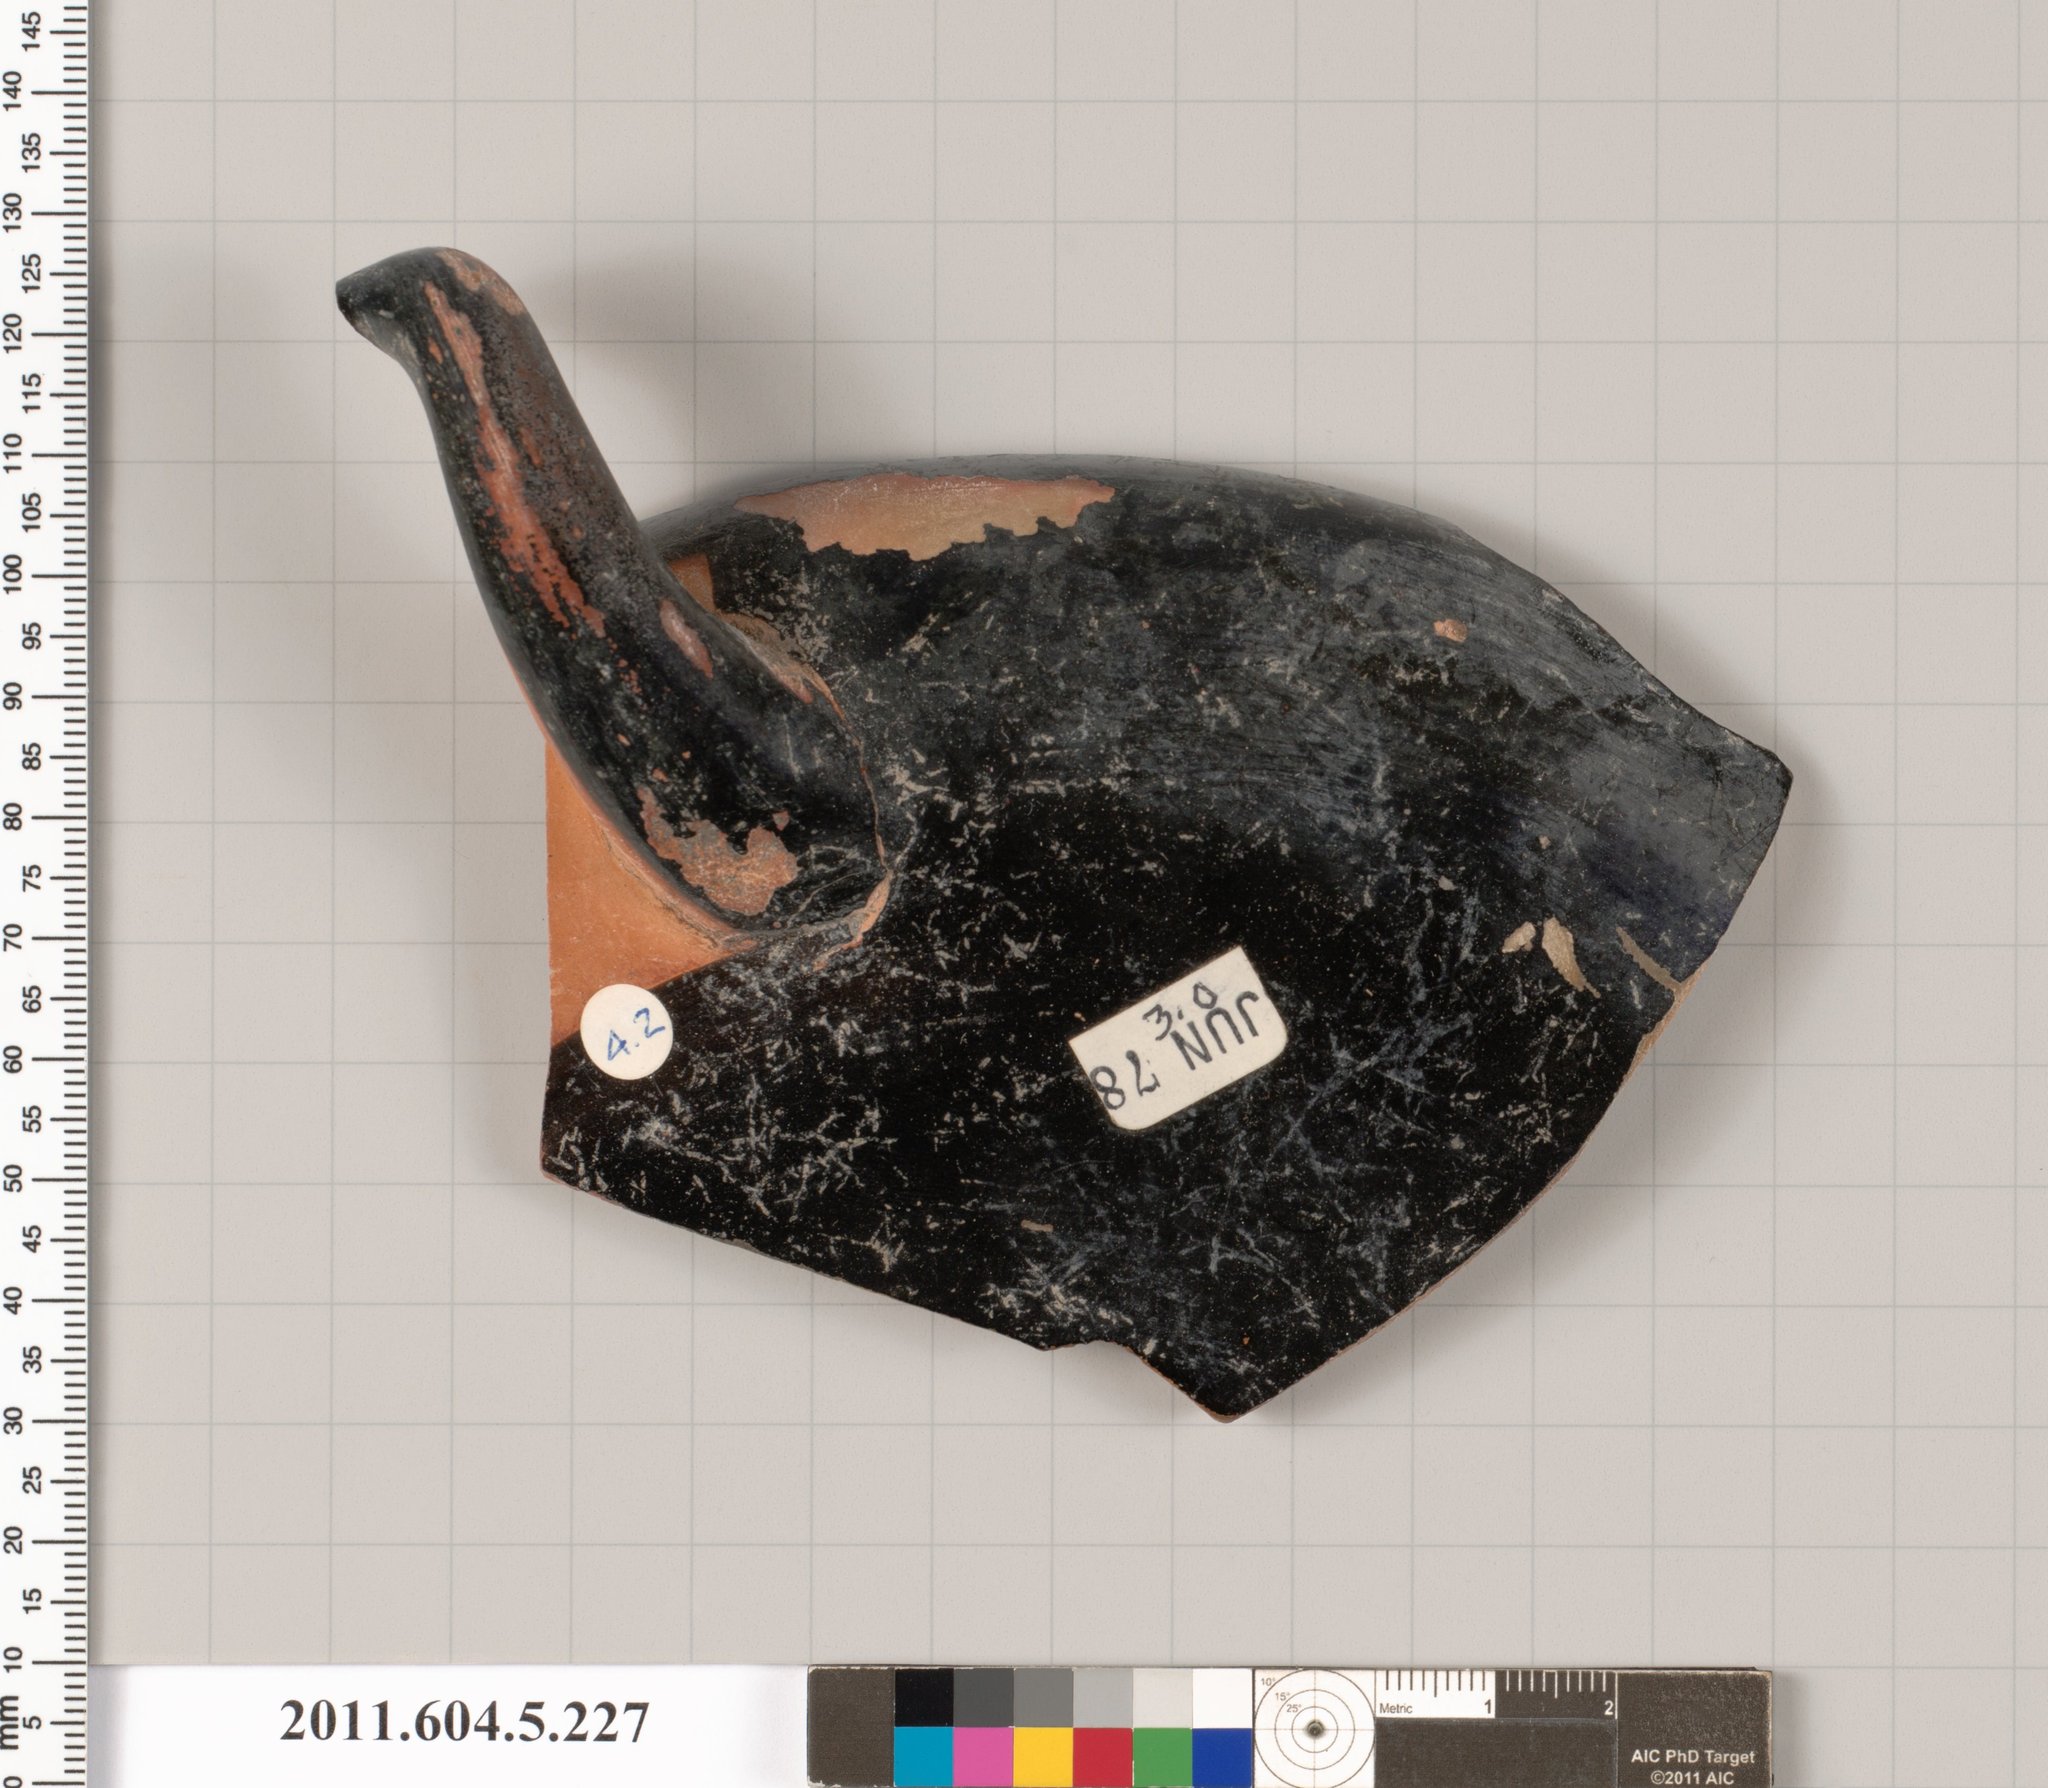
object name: kylix fragment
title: Terracotta rim fragment of a kylix (drinking cup)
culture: greek, attic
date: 600-401 BCE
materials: terracotta